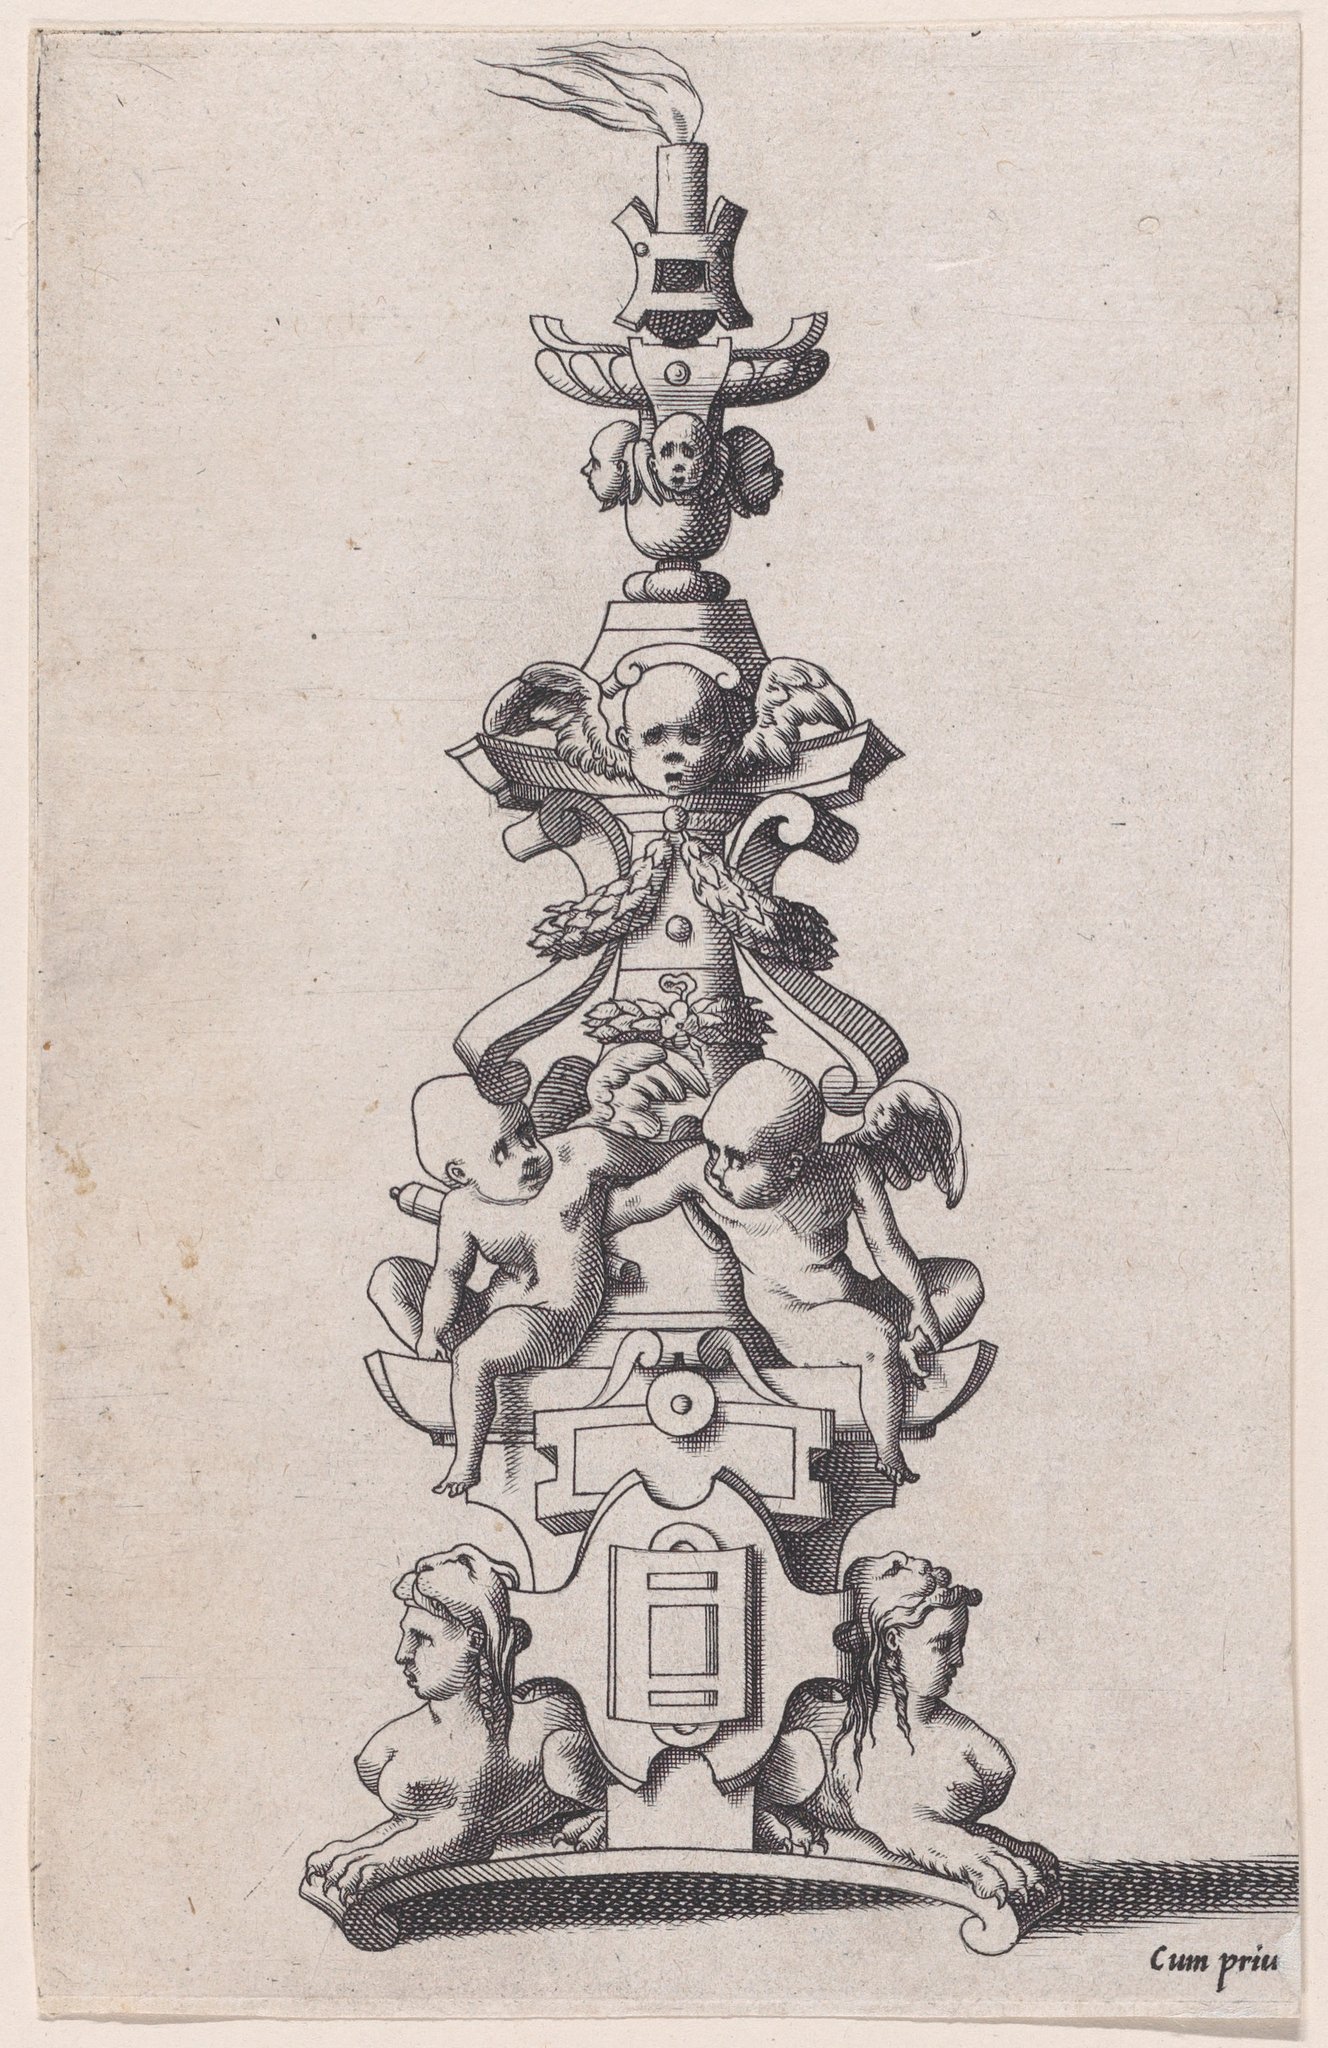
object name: print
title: Candlestick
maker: rené boyvin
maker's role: artist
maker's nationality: french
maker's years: 1525-1598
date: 1525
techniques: engraving